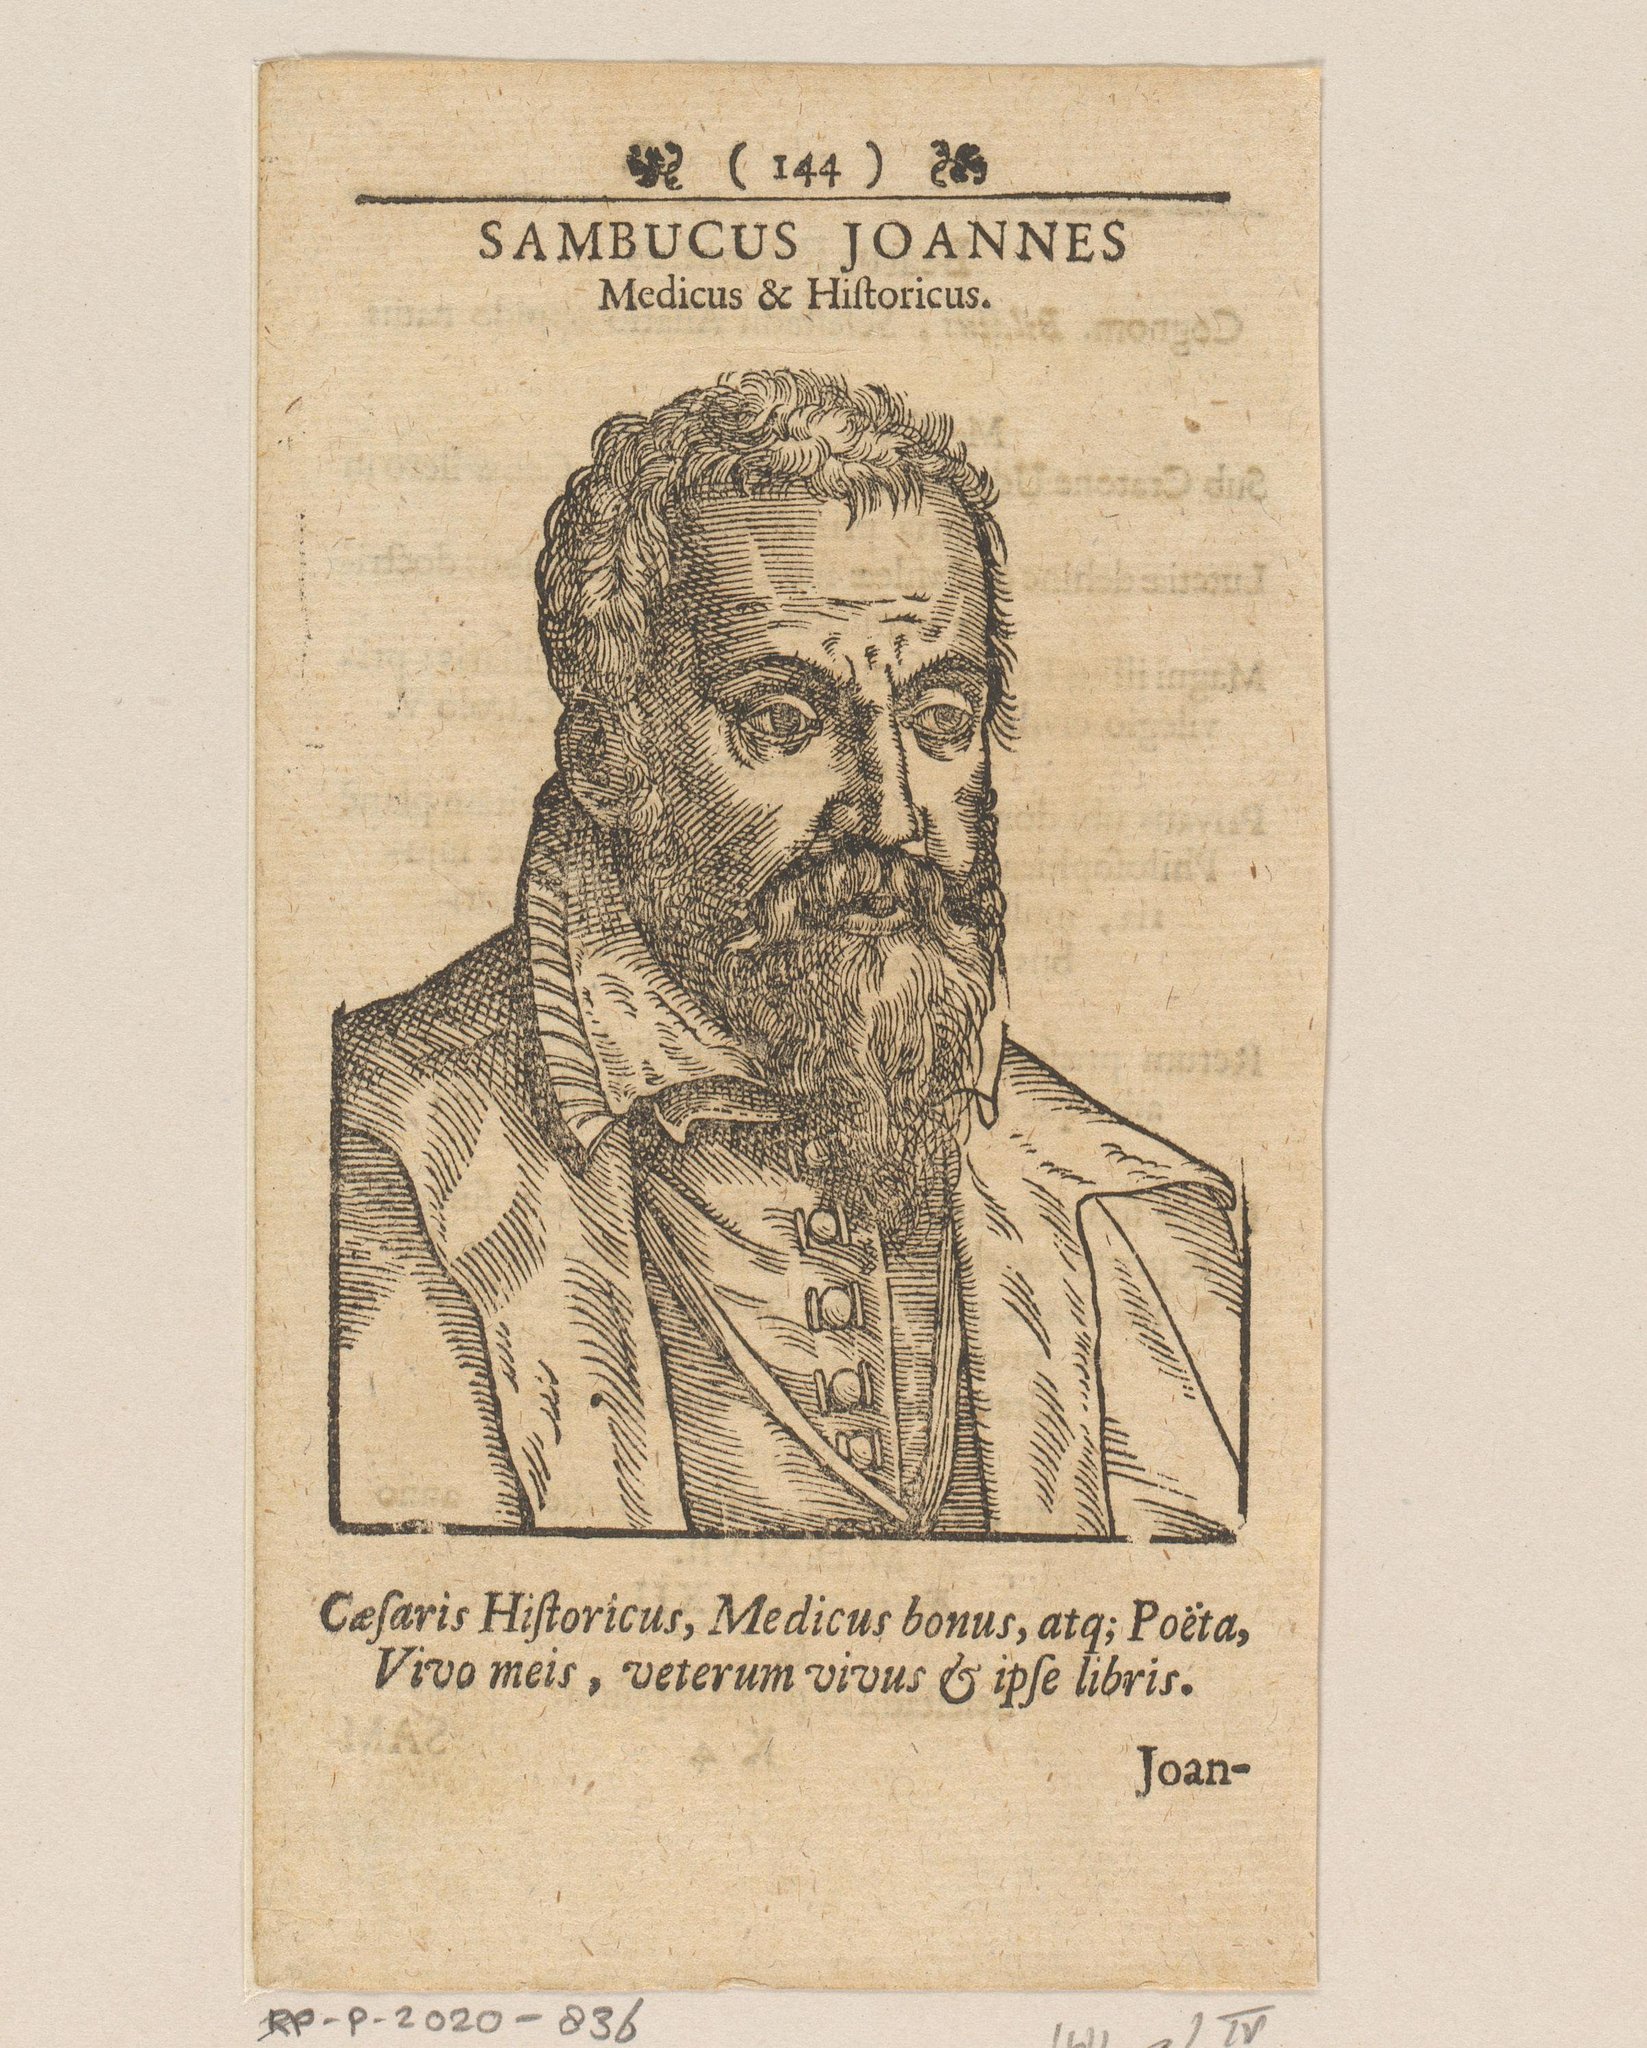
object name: book illustration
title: Portret van Johannes Sambucus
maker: johann balthasar diehl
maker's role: printer, publisher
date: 1719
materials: paper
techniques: letterpress printing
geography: frankfurt am main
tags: vienna, johannes sambucus, historical persons, physician, doctor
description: Prent uit: Reusner, Nikolaus. Icones sive imagines virorum literis illustrium qui seculo XV. (...). Frankfurt am Main: Johann Balthasar Diehl, 1719, p. 144. Prent voor het eerst verschenen in de eerste editie van 1587.